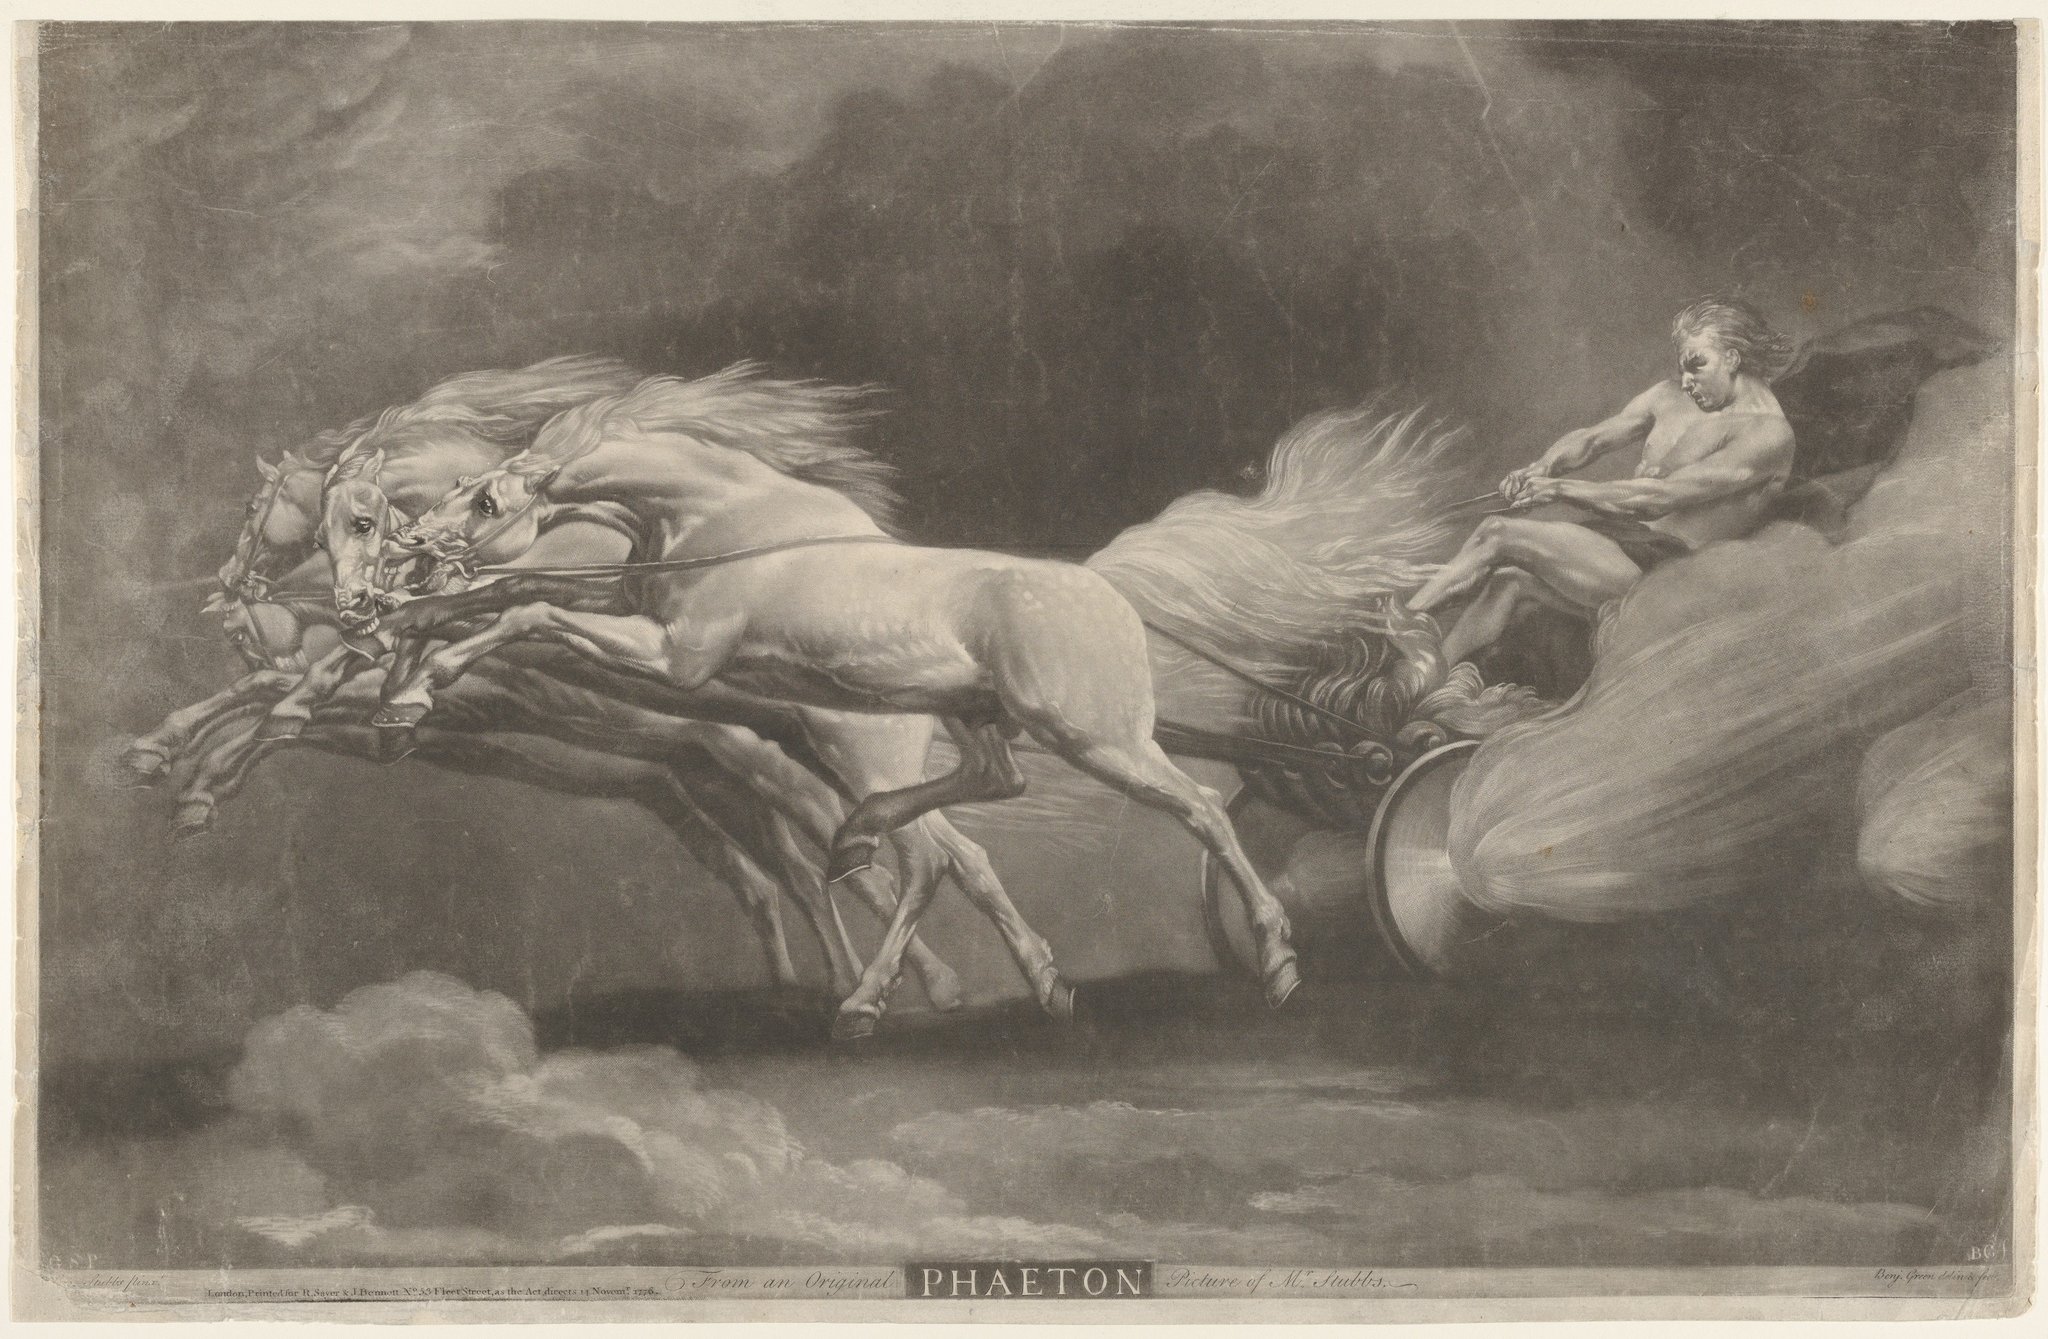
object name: print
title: Phaeton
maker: benjamin green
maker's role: artist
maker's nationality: british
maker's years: 1739-1798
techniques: mezzotint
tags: men,carriages